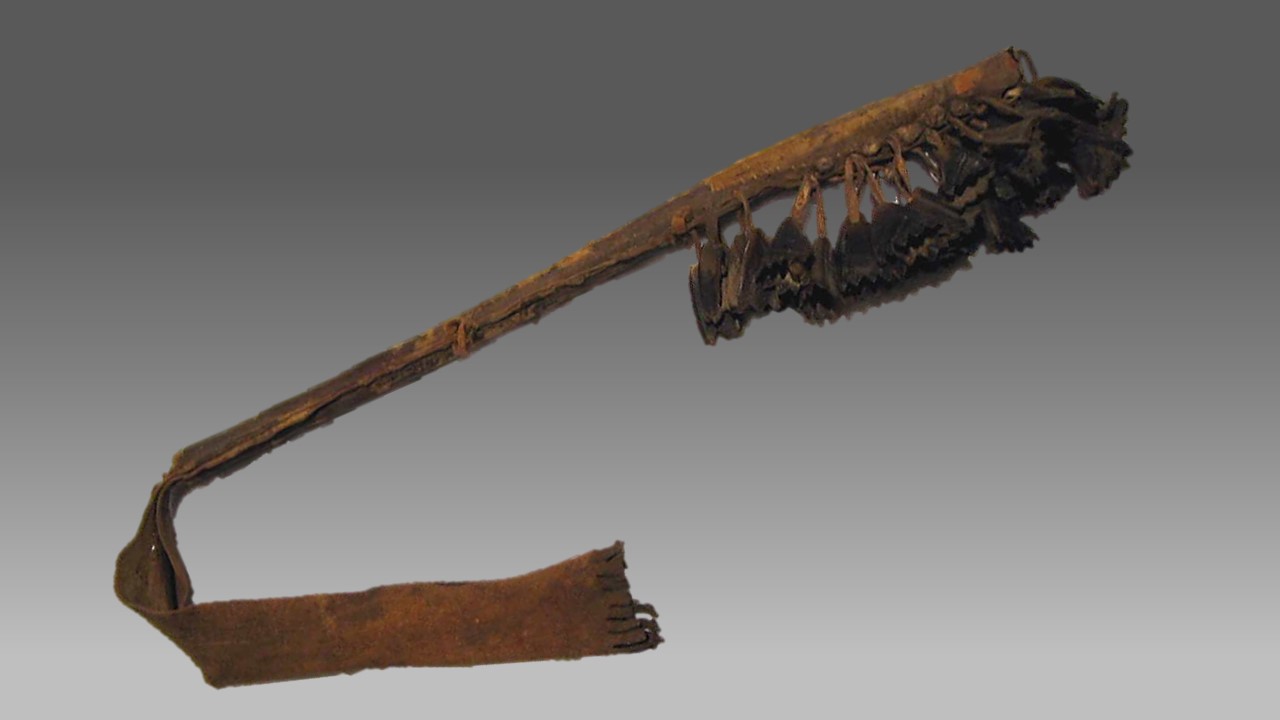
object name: dew claw rattle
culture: native american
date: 1801-1900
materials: wood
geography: united states